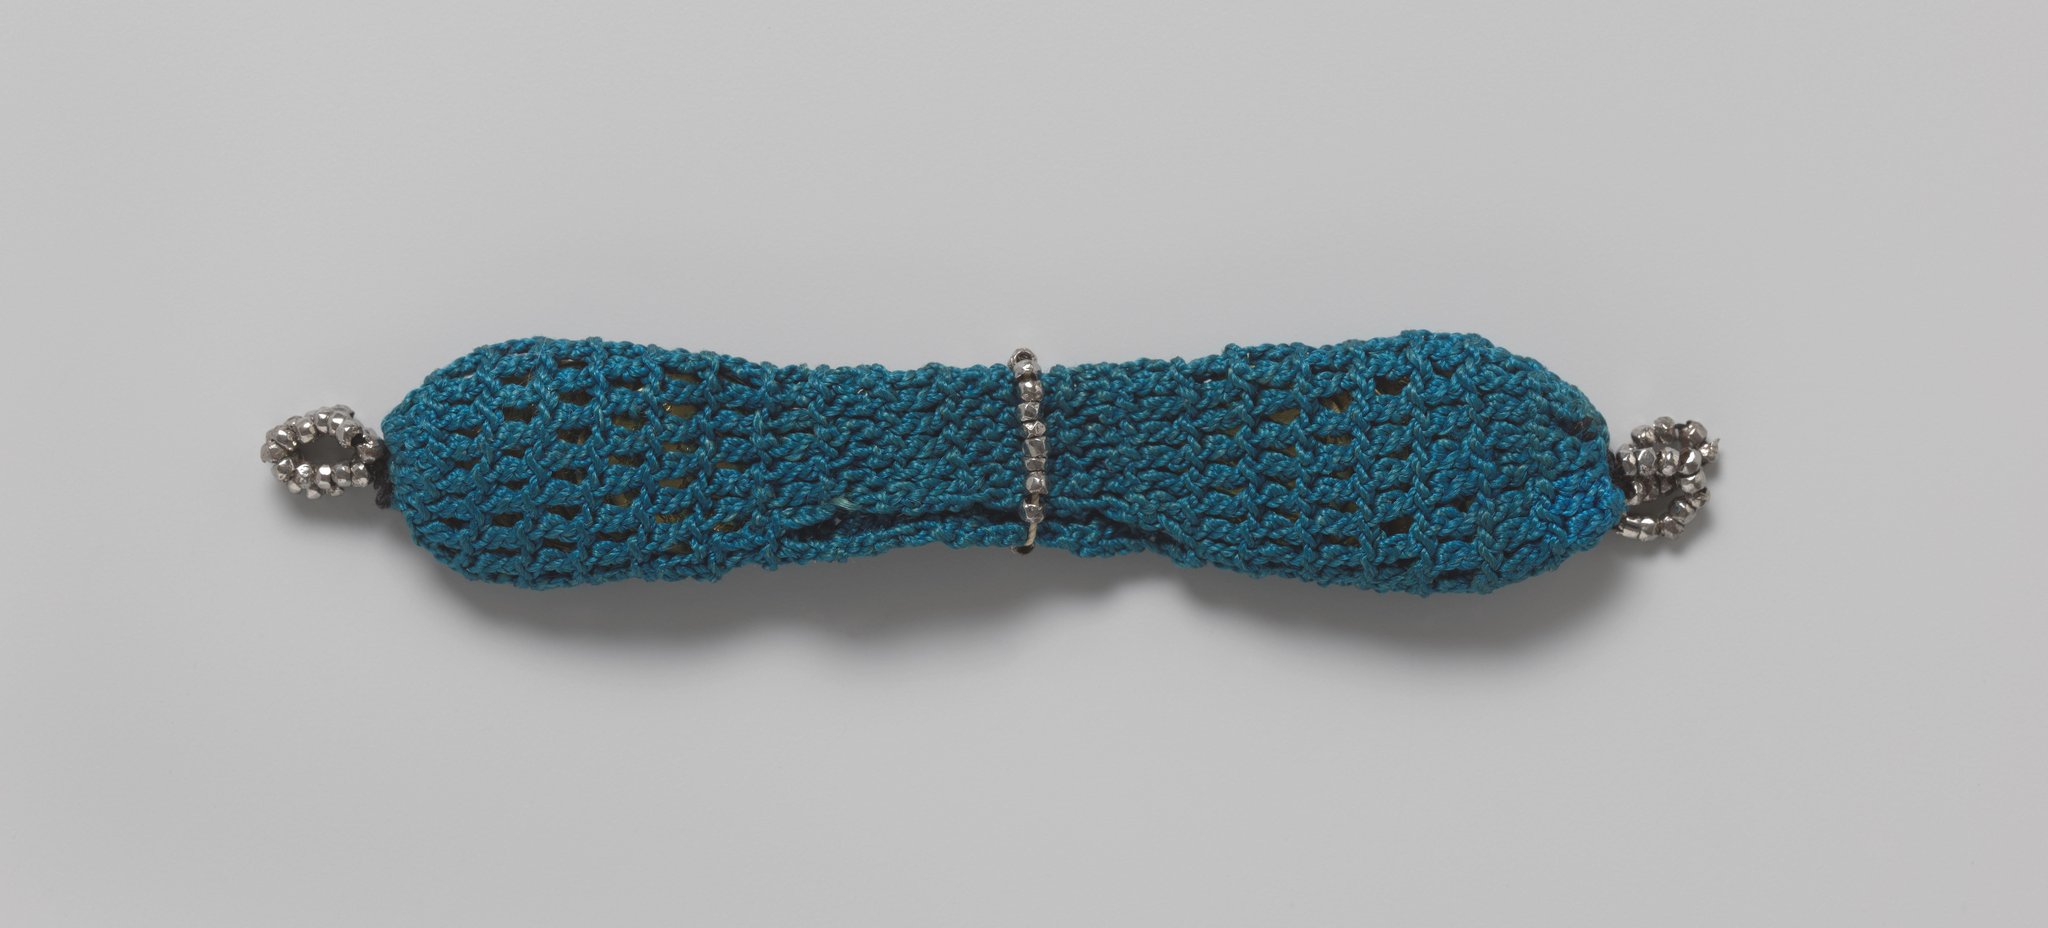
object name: gaming counter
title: Beurs, blauw, gehaakt. Met zestien speelmarken (spielmarken)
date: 1880-1890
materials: cotton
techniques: crochet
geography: netherlands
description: Beurs, blauw, gehaakt. Met zestien speelmarken (spielmarken). Muntlek.